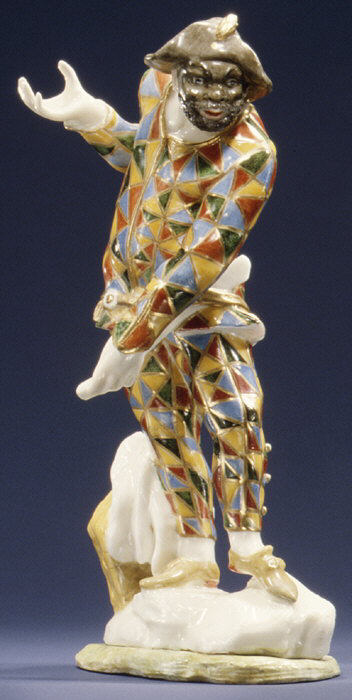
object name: figure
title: Harlequin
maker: real fabrica de buen retiro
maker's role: factory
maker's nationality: spanish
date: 1760-1770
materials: soft paste porcelain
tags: men